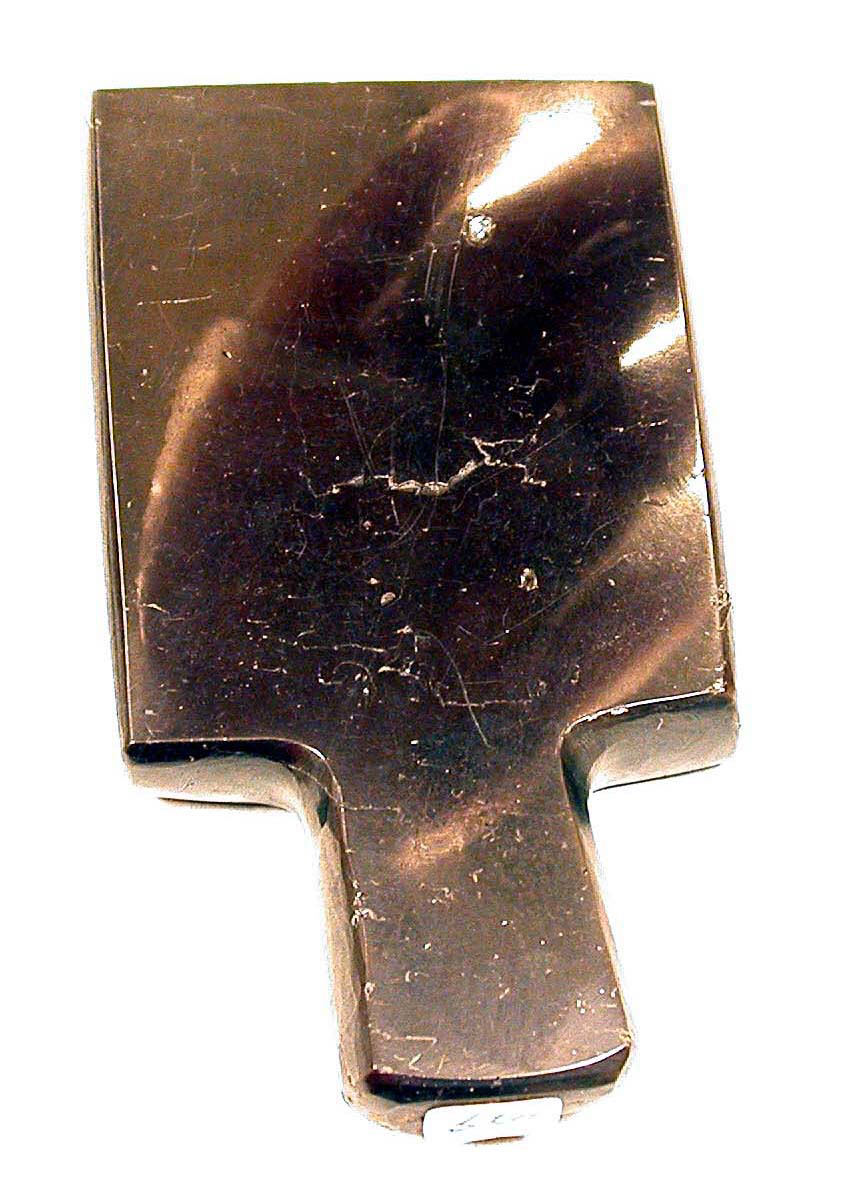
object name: mirror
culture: chavin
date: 1501-1600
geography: peru